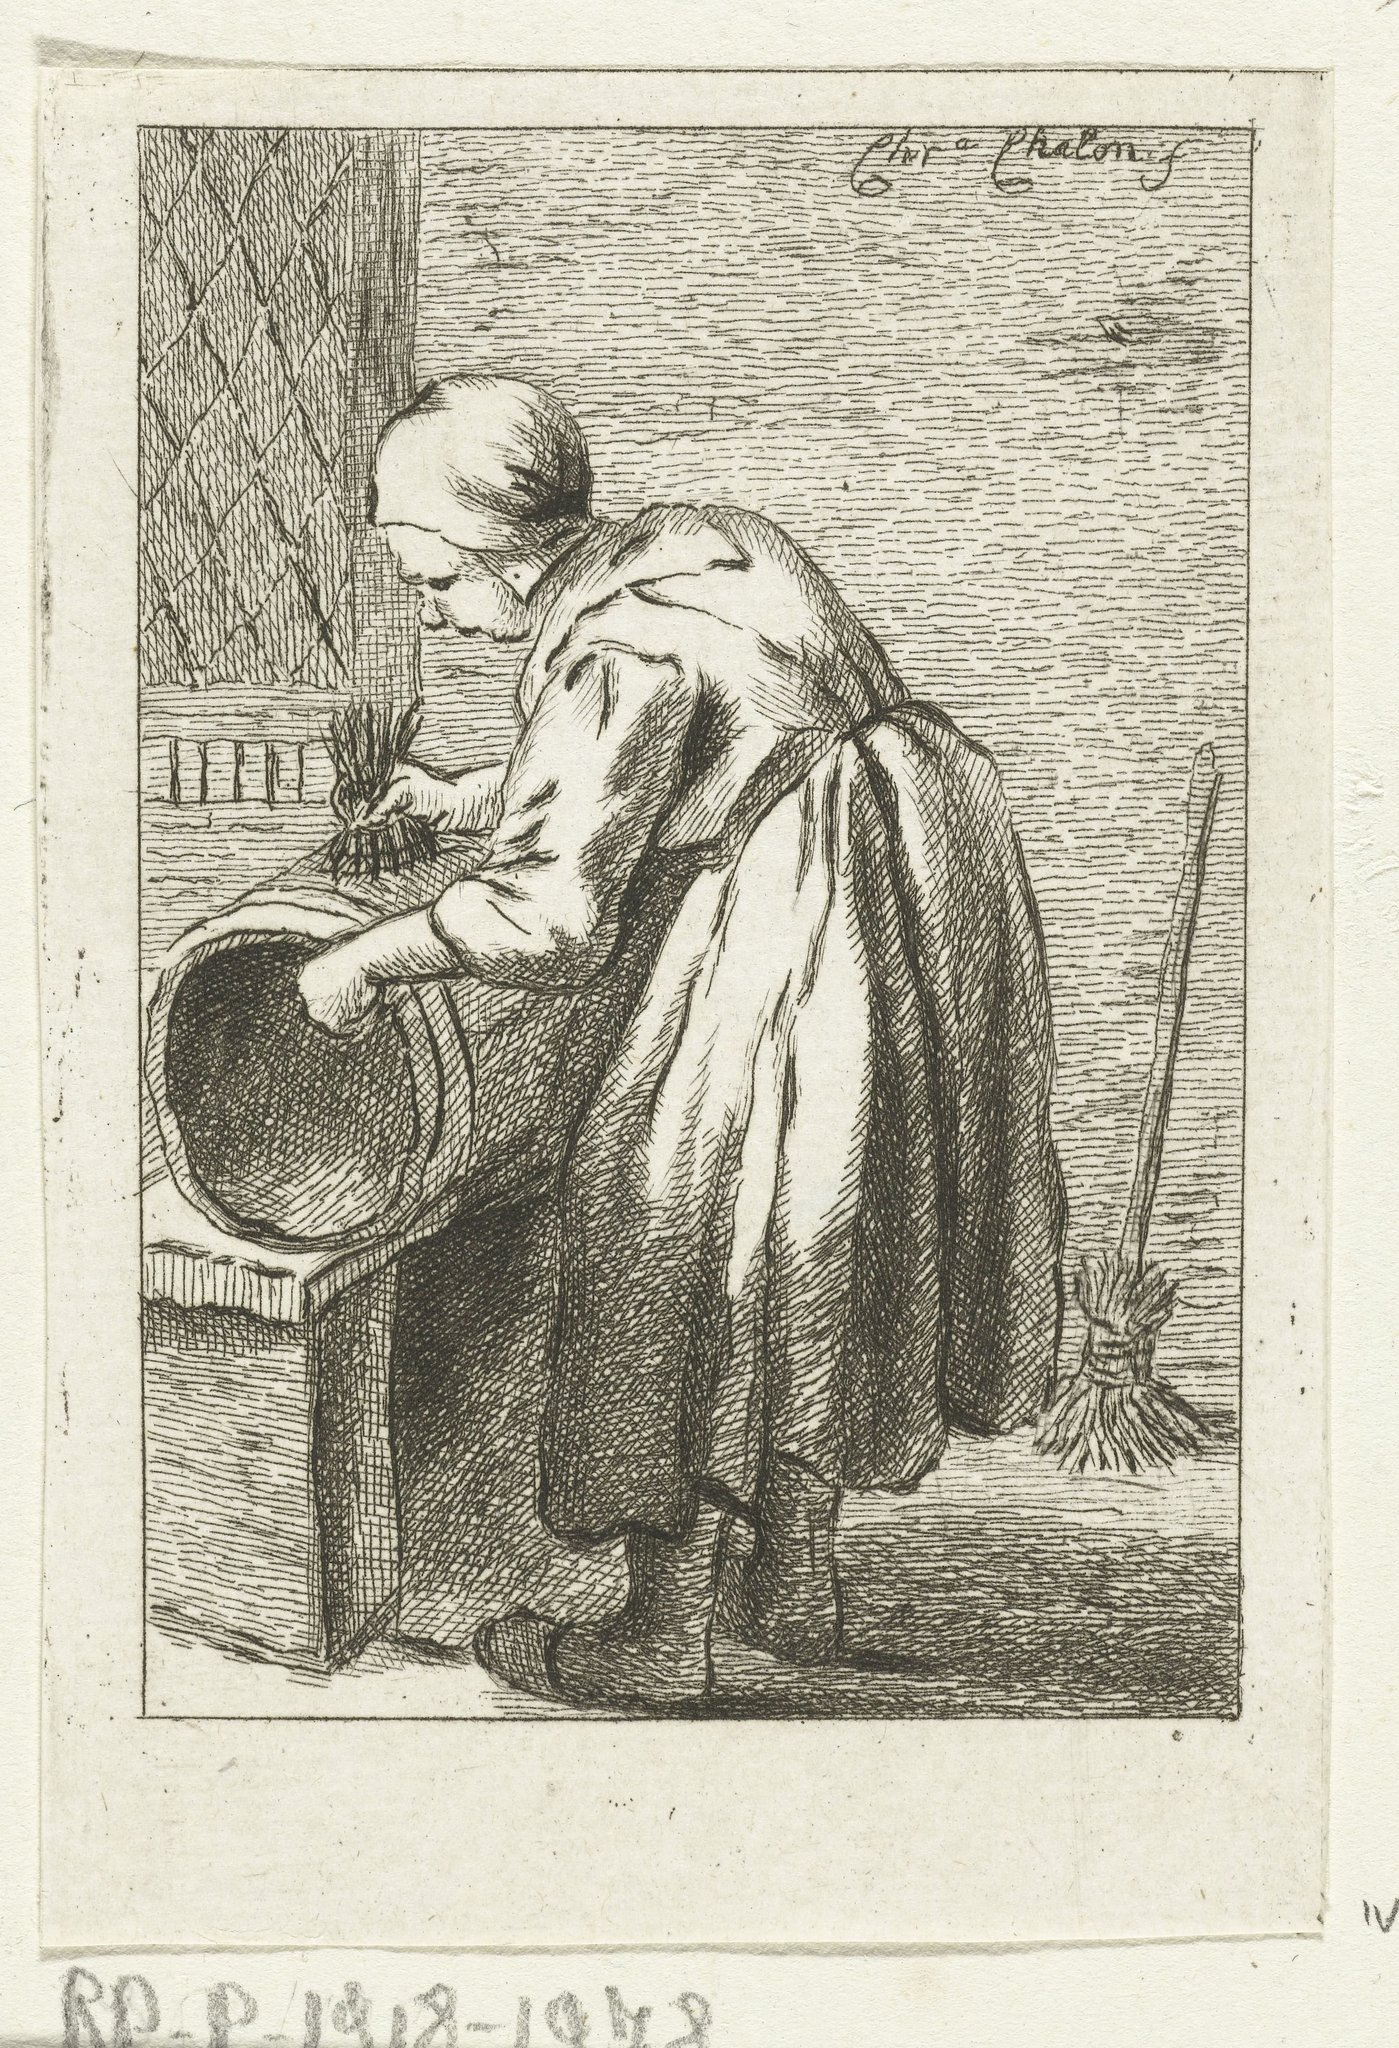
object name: print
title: Boenende vrouw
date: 1779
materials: paper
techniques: etching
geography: leiden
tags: wooden container: barrel, cask, bucket, farmers - aa - female farmer, farmer's wife, cleaning (the house)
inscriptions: collector's mark: Lugt 2233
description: Een boerin maakt een ton schoon met wat hooi.